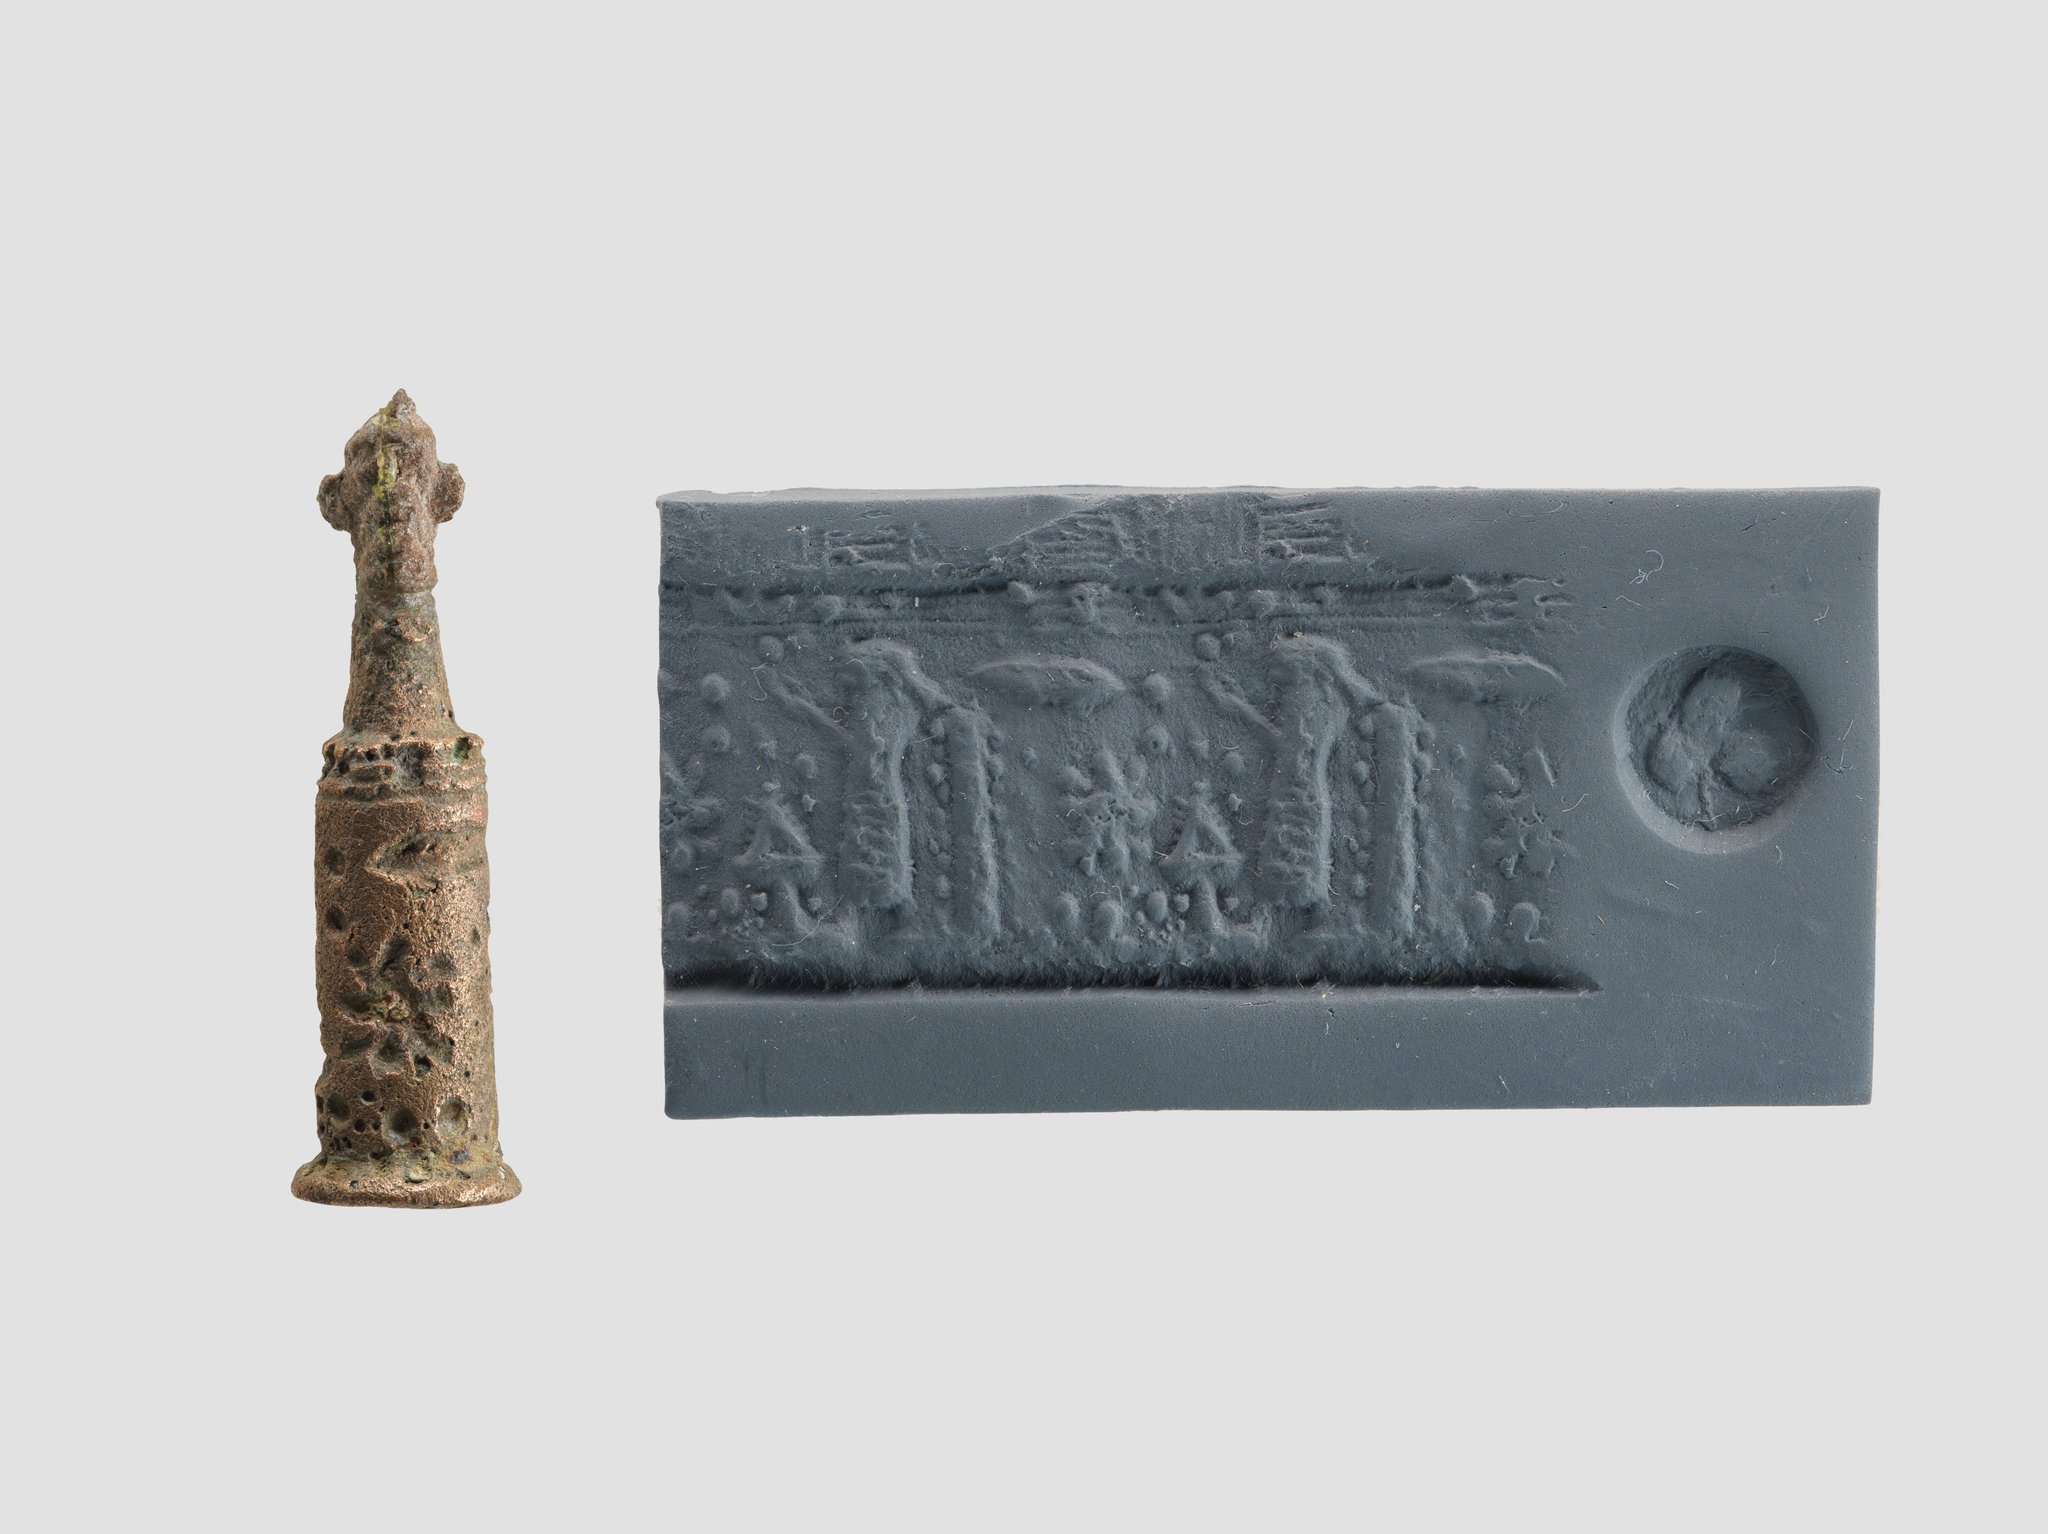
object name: stamp cylinder seal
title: Stamp-cylinder seal with cultic scene, surmounted by (a plaster copy?) double-faced Pazuzu head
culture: urartian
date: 800-601 BCE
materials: alloy, bronze, copper, plaster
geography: urartu